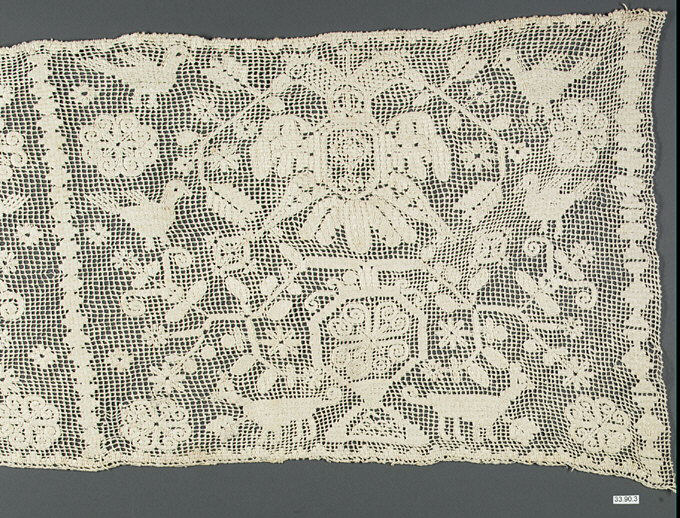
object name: border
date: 1601-1700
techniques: embroidery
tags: birds,flowers